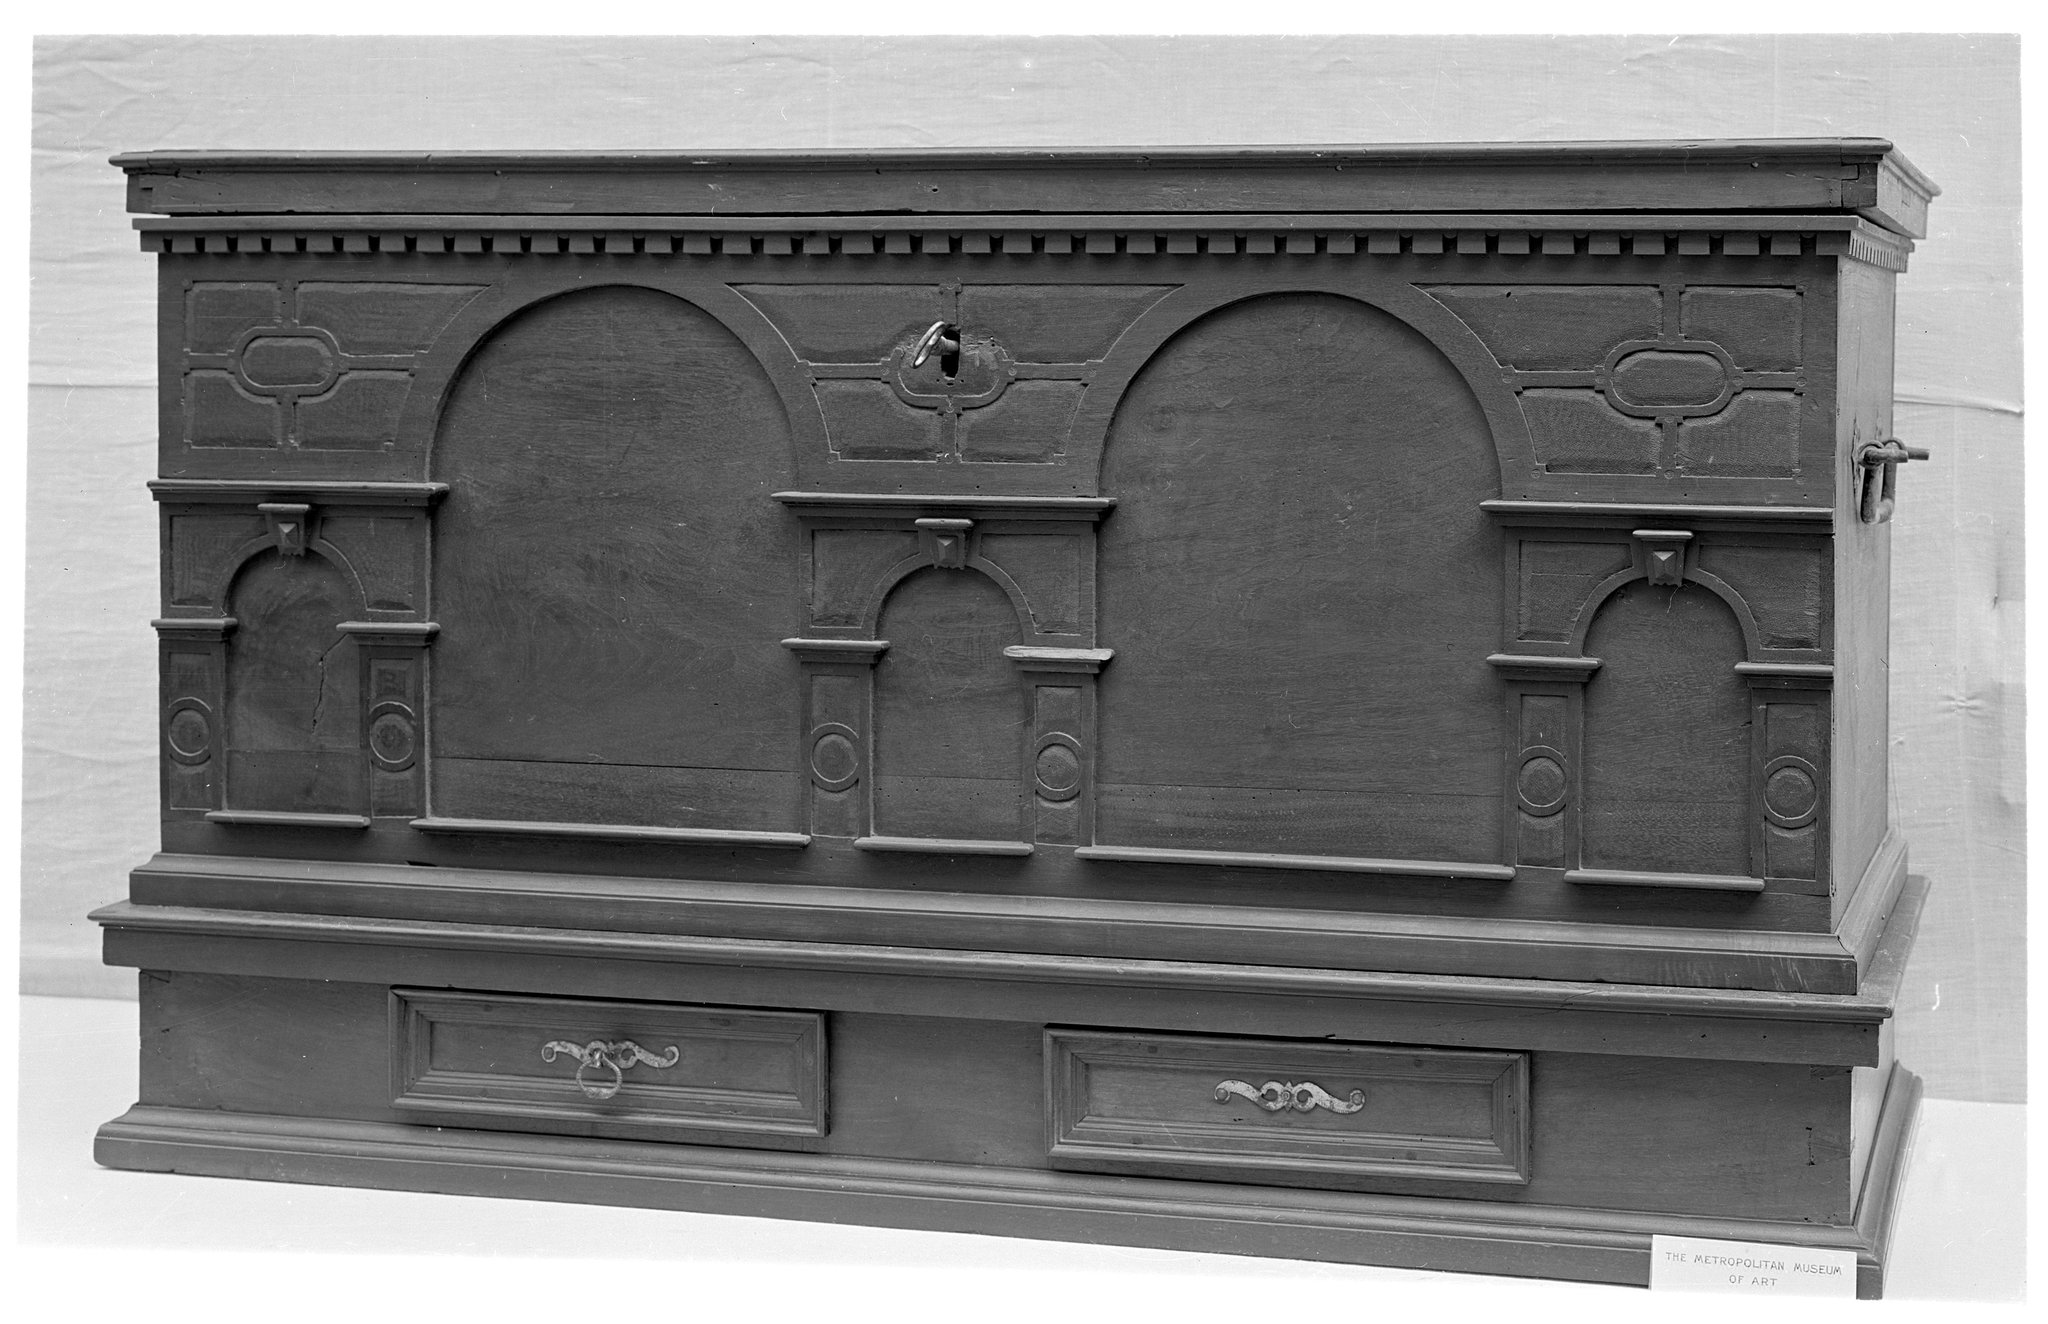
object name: chest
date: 1601-1700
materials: wood